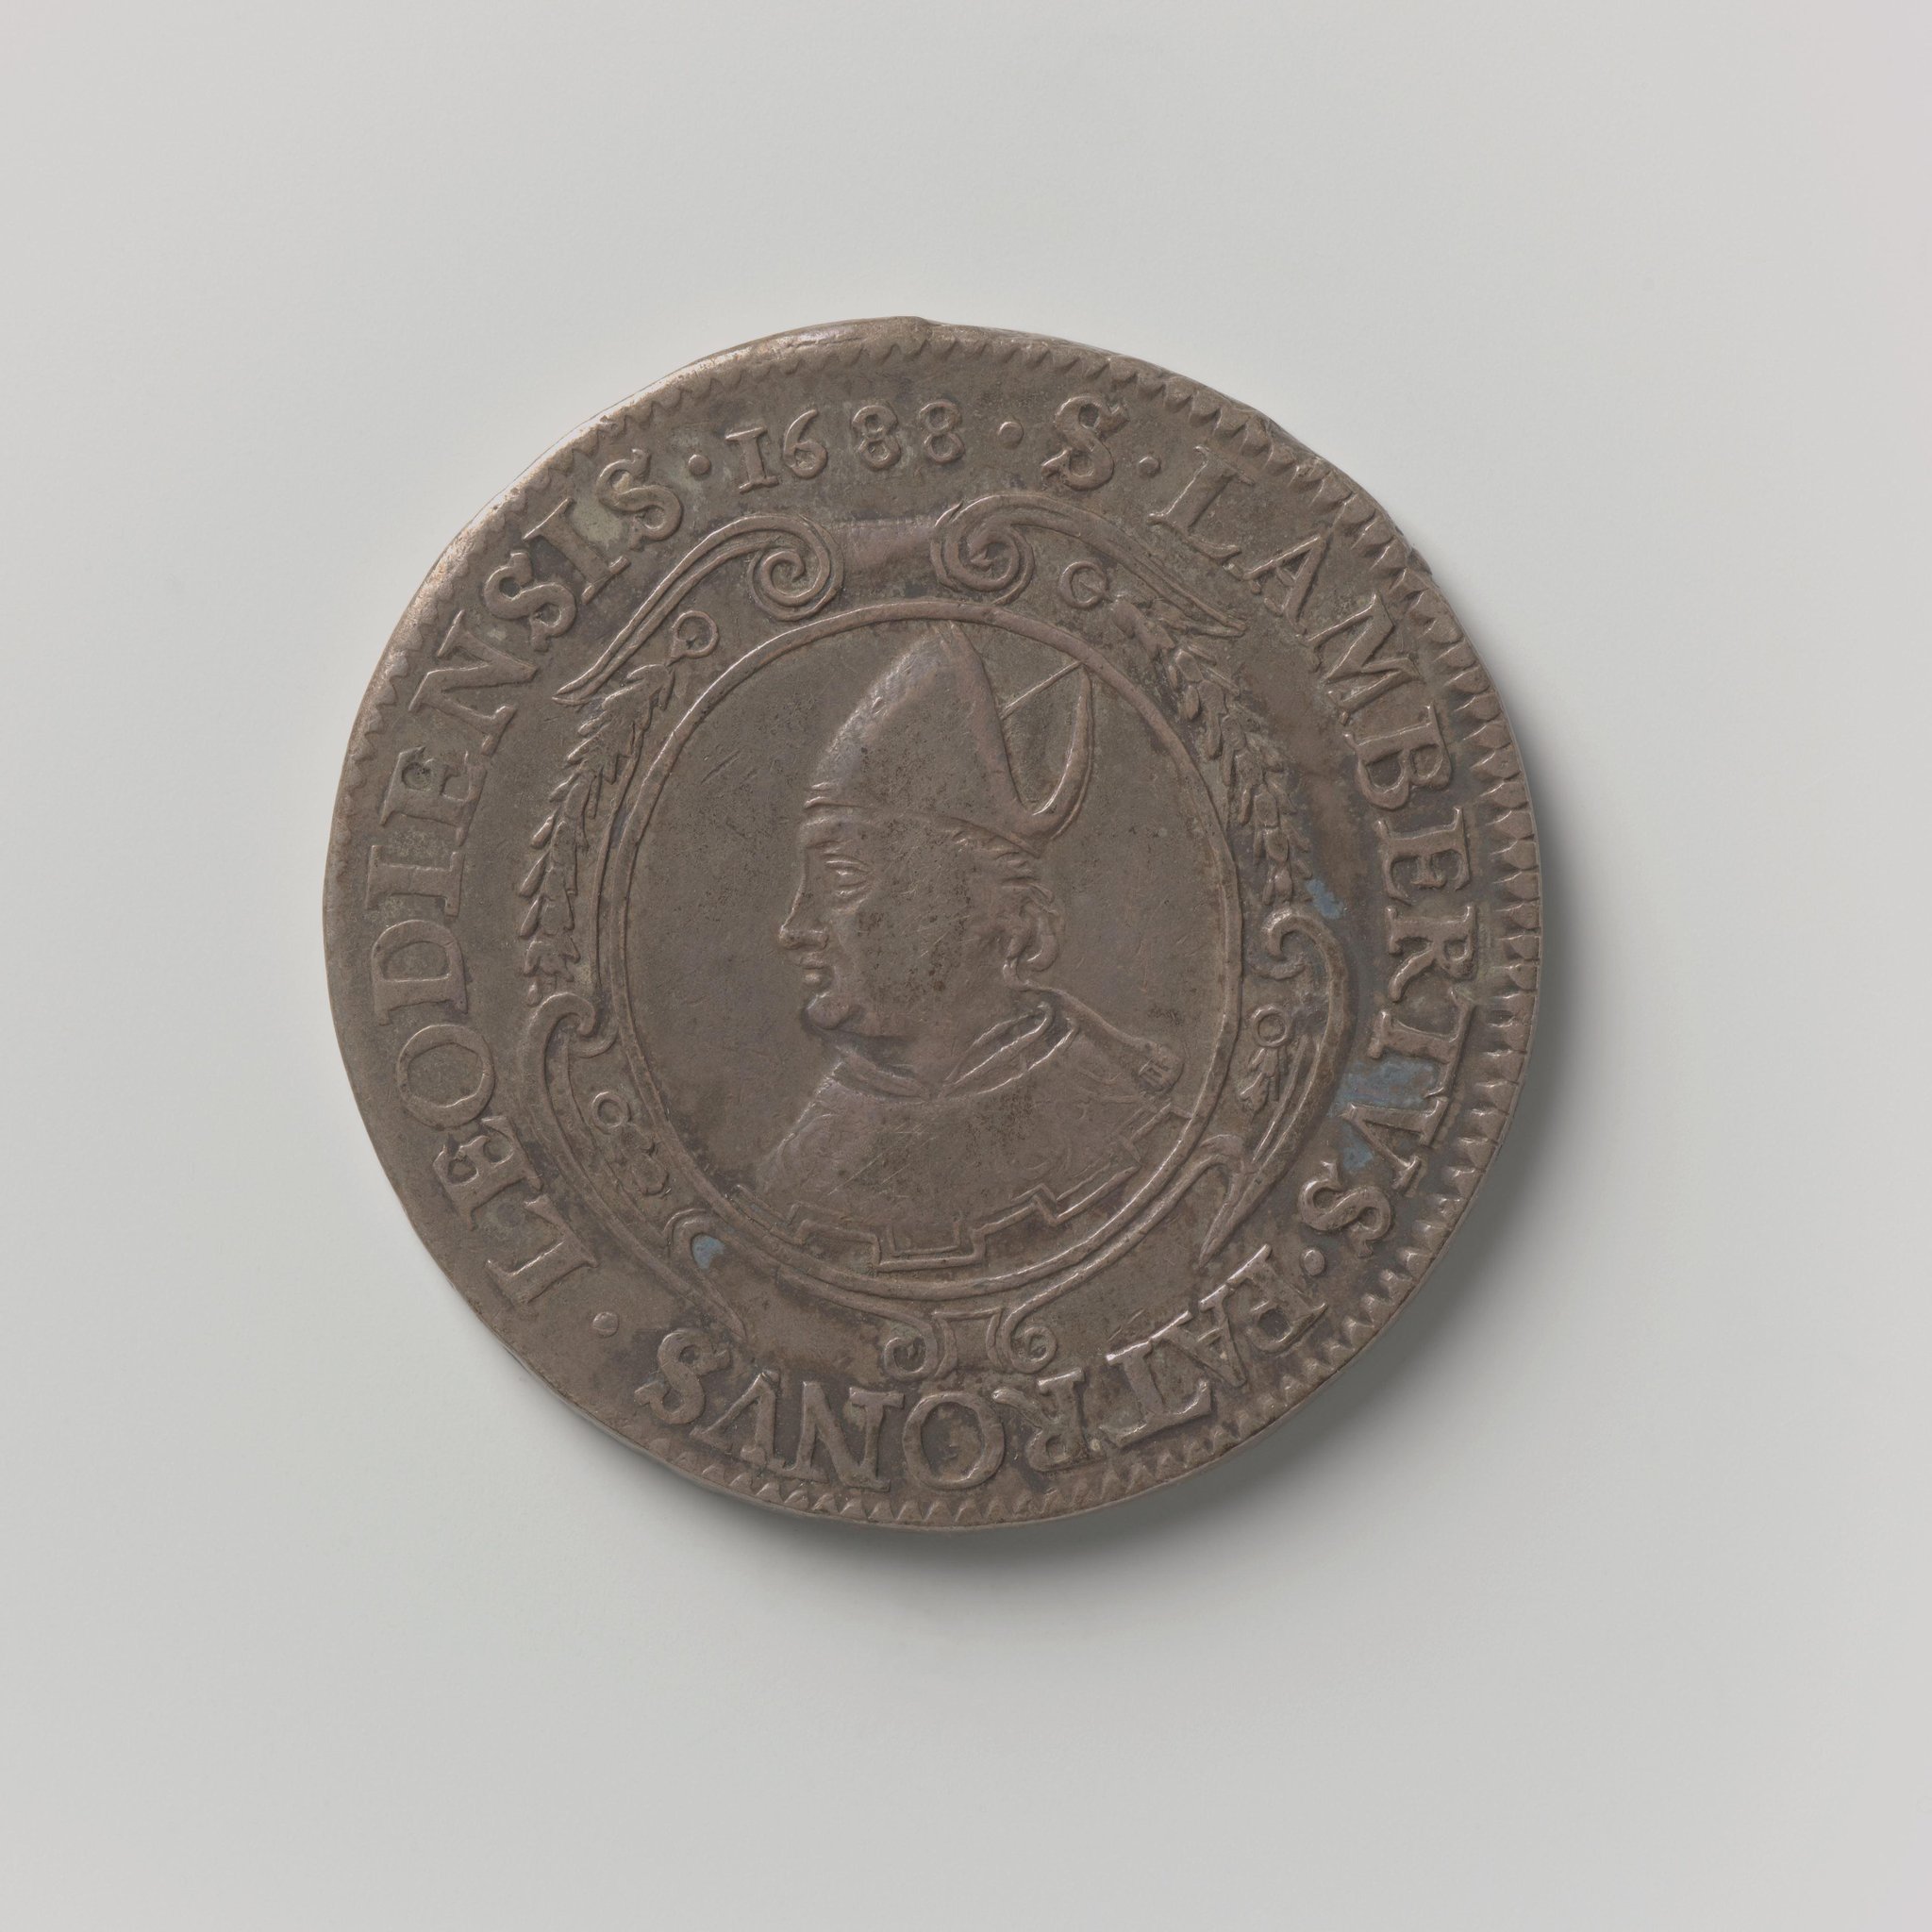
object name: coin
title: Bisdom Luik, sede vacante, patagon, 1688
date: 1688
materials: silver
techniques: striking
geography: liège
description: Zilveren munt. Voorzijde: binnen versierd ovaal portret van de heilige Lambertus naar links. Jaartal bovenaan in omschrift. Keerzijde: gekroond samengesteld wapenschild. Randschrift [?].